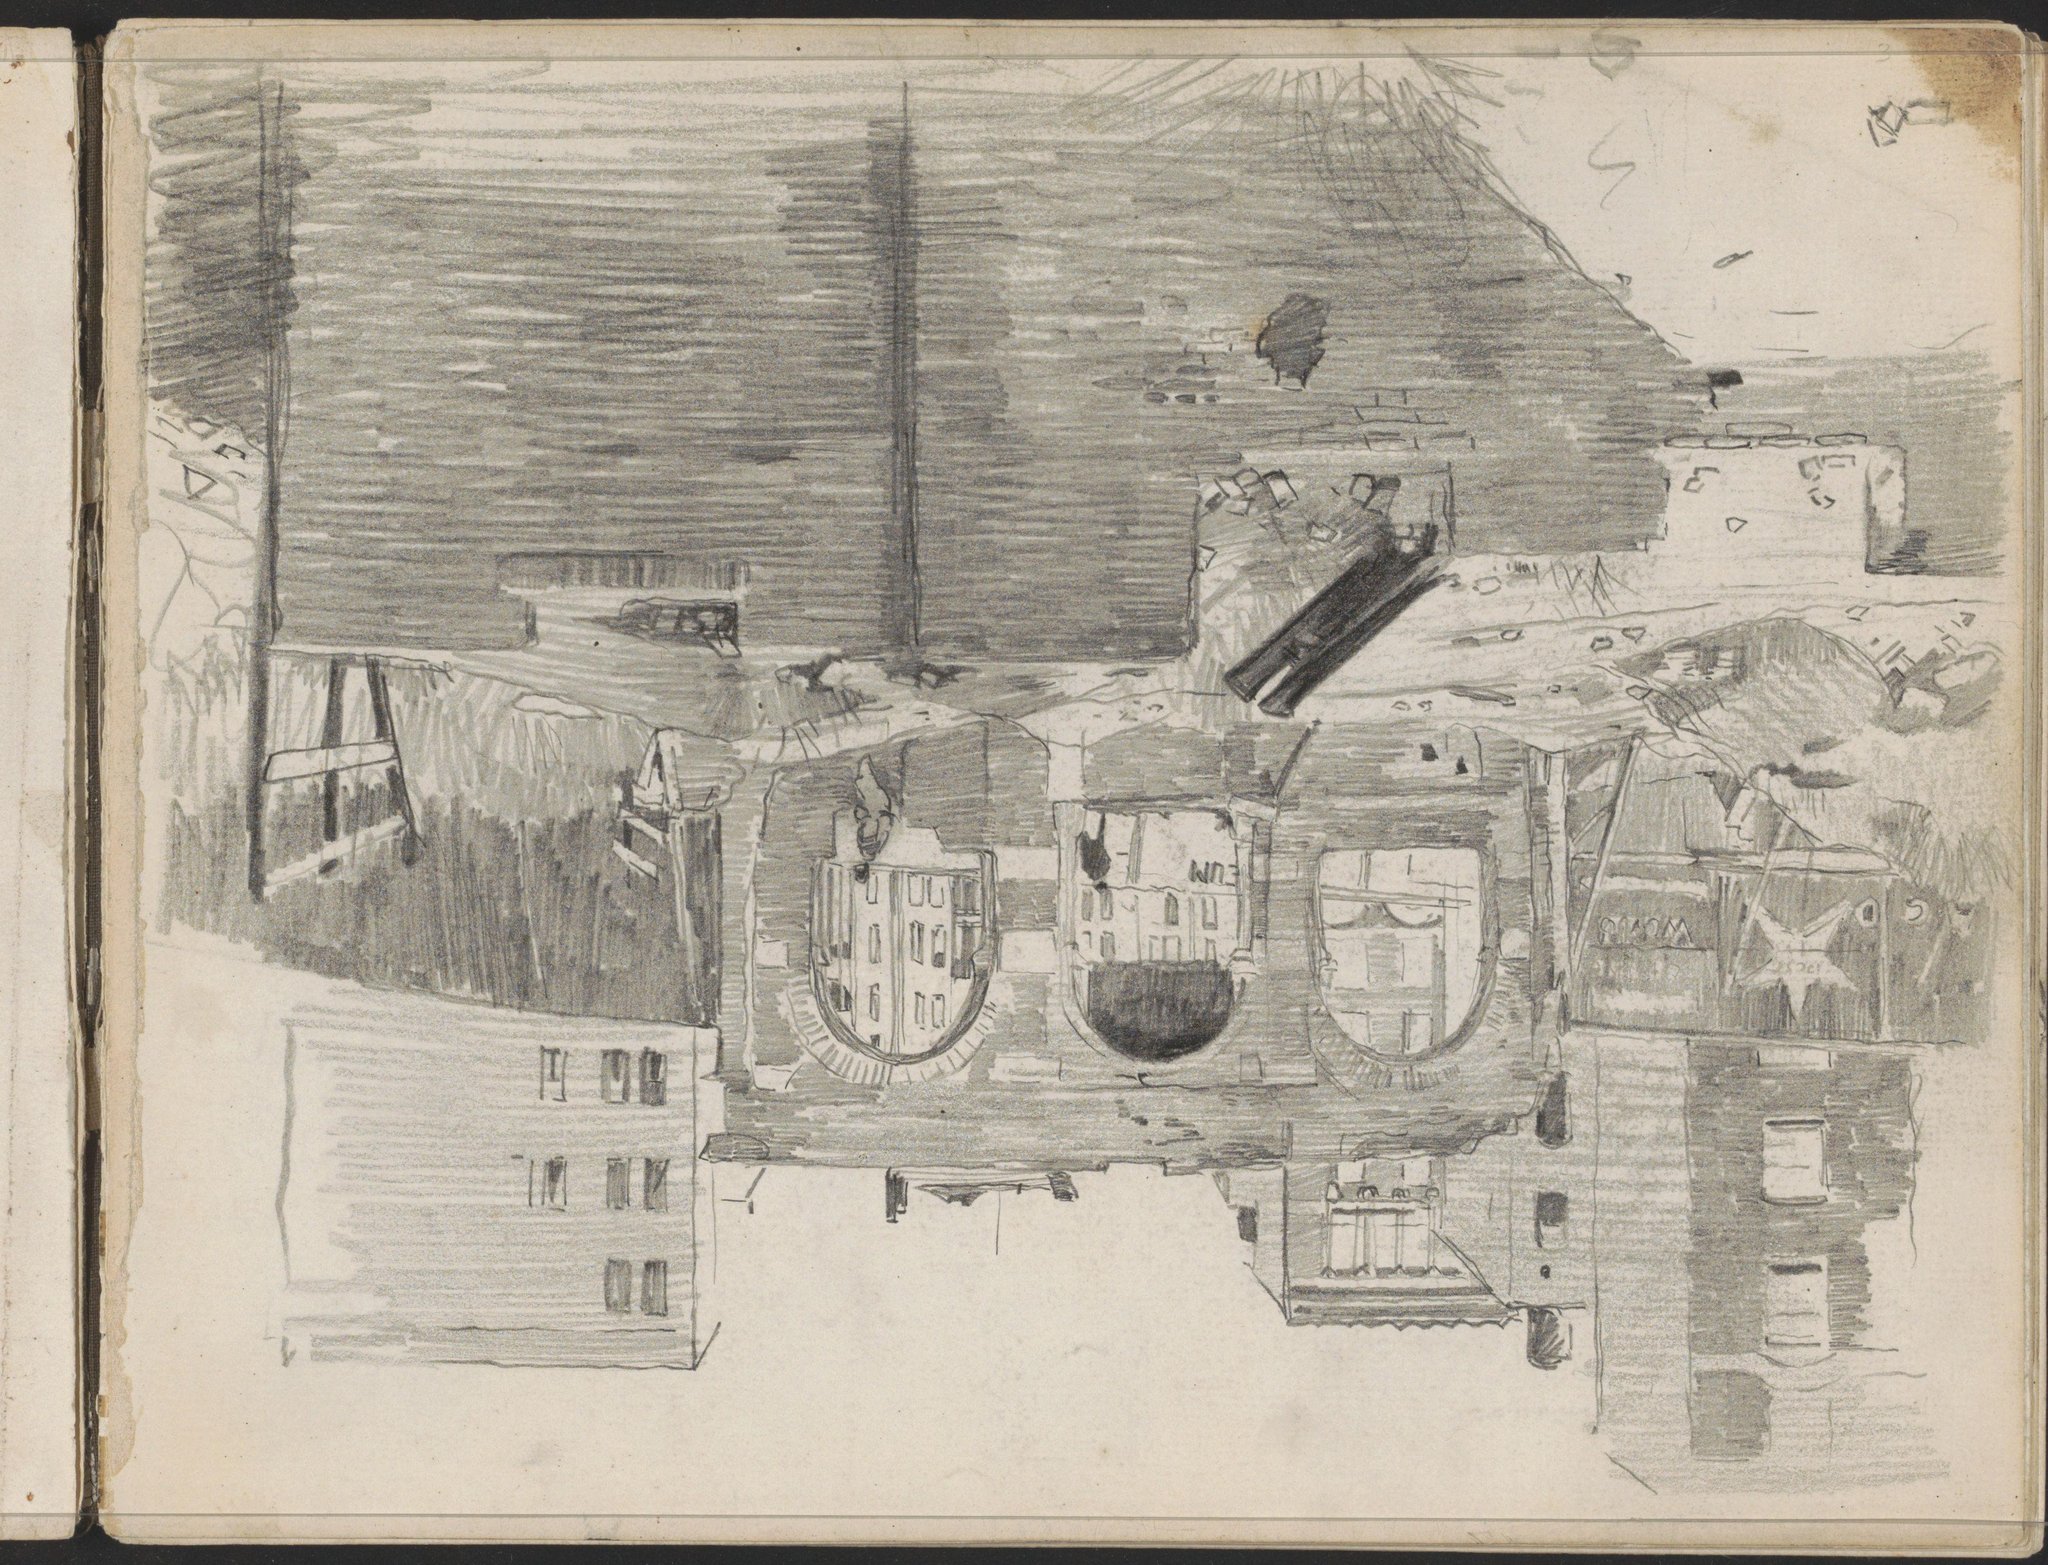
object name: sketchbook leaf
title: Gezicht op Post Street te San Francisco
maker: willem witsen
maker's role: draughtsman, painter, print maker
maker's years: 1860-1923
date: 1915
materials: paper, pencil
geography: san francisco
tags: city-view, and landscape with man-made constructions, ruin of a building ~ architecture, civic architecture; edifices; dwellings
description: Voorstudie voor de ets 'Post Street, San Francisco', ca. 1915-1919.